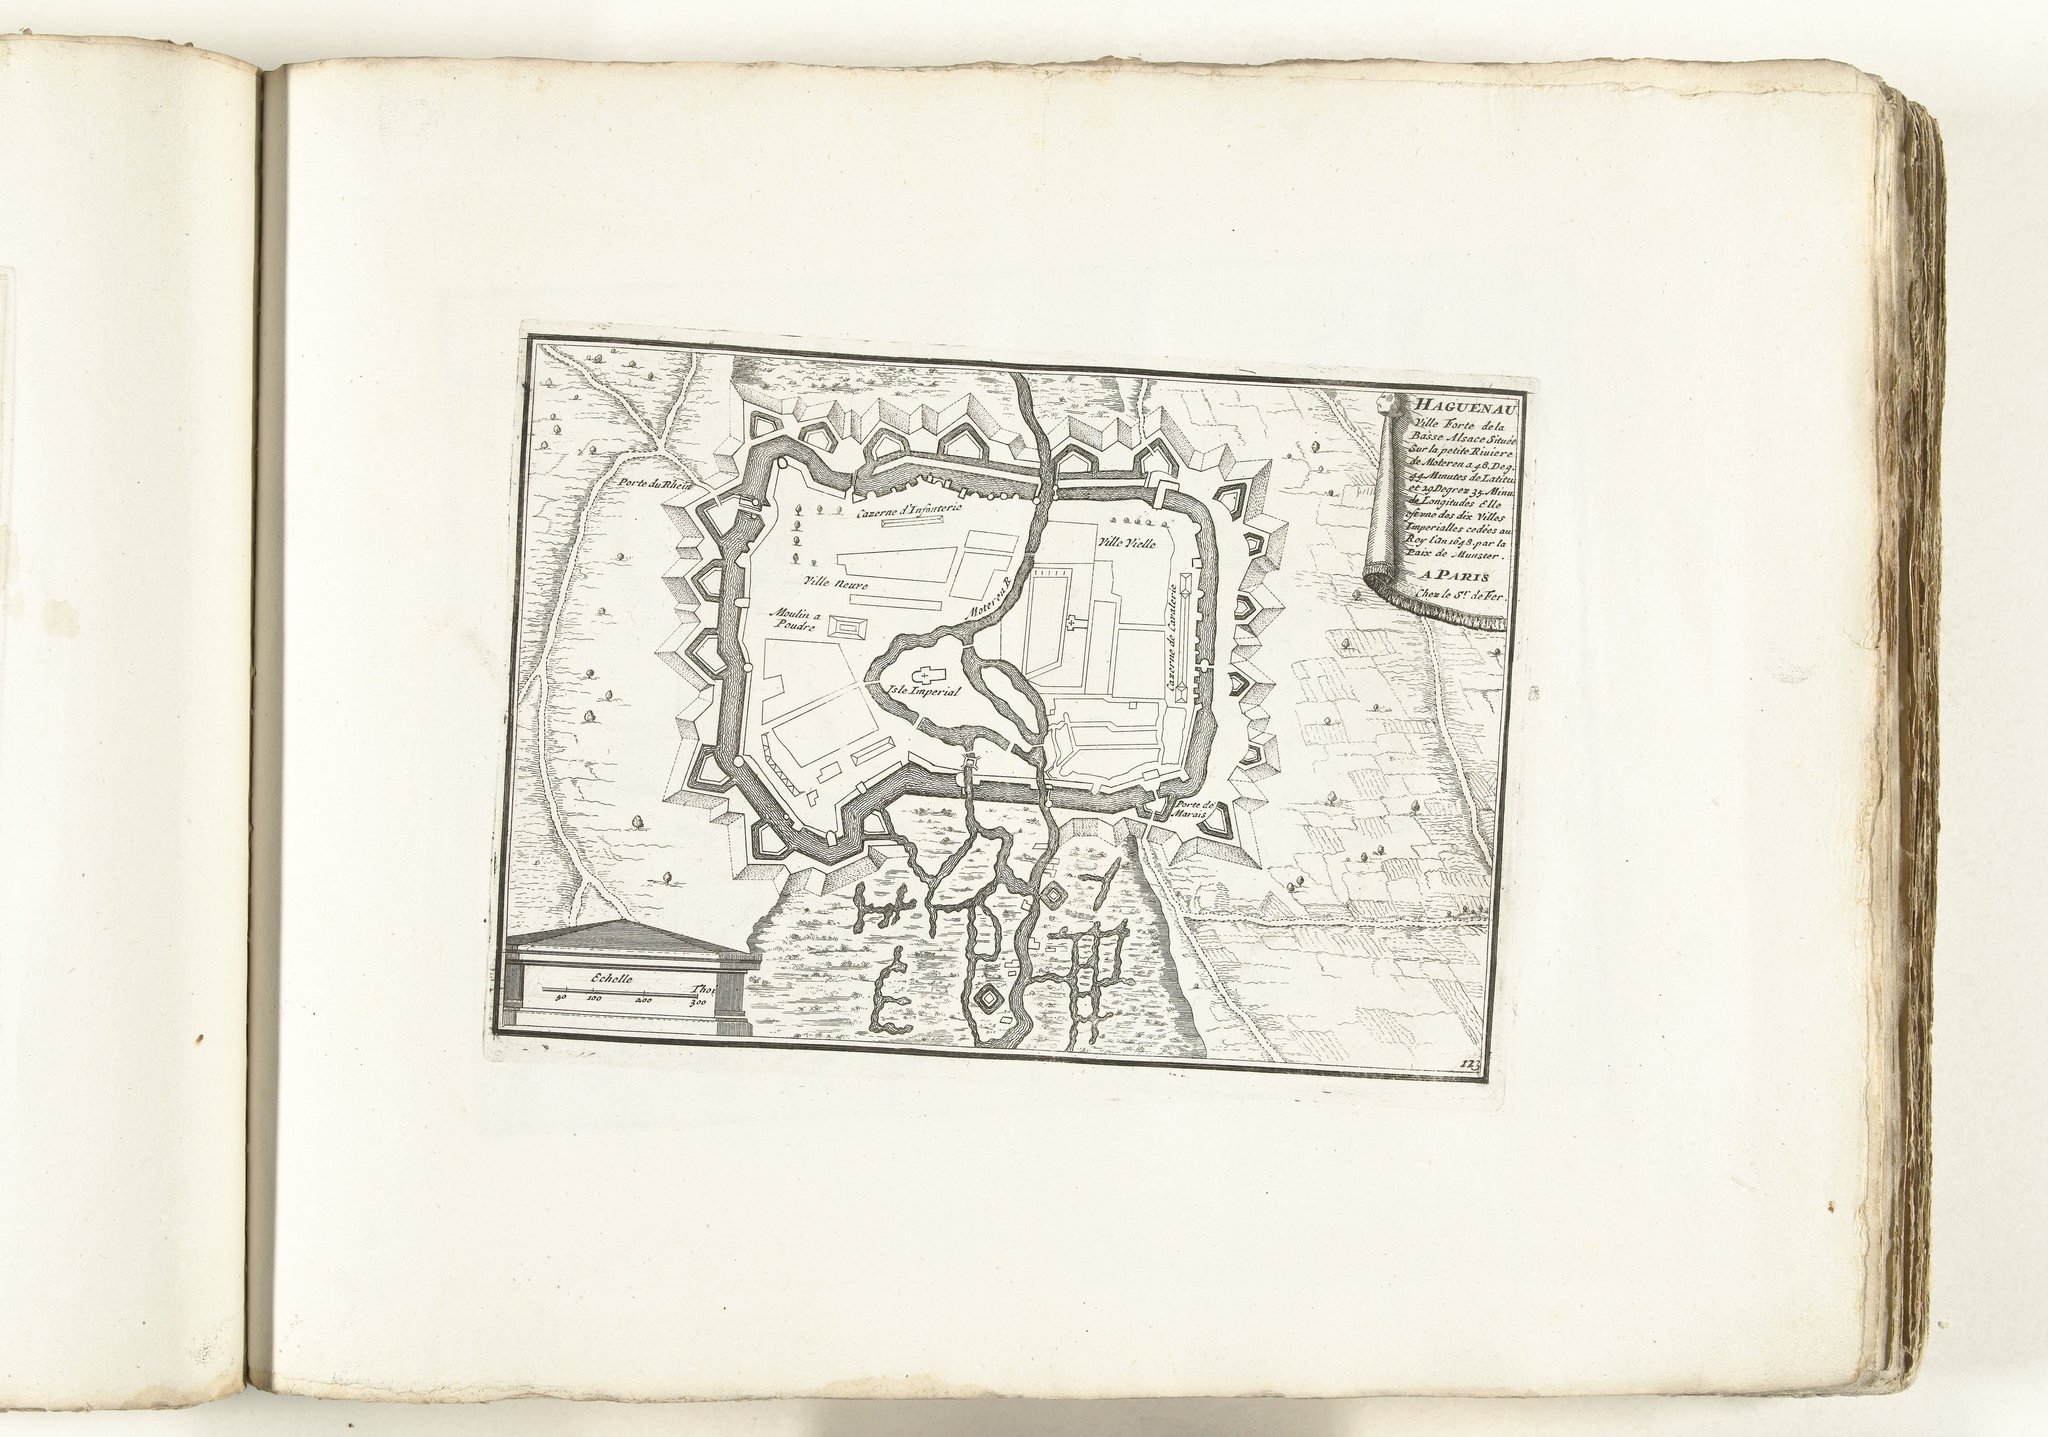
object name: map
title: Les Forces de l'Europe, Asie, Afrique et Amerique, ou description des principales villes avec leurs fortifications. Dessignées par les meilleurs ingenieurs, particulierement celles qui sont sous la domination de la France (...) et ornées de plusieurs superbes edifices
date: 1702-1703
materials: paper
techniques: etching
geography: paris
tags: fortress, maps of cities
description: Plattegrond van de versterkingen om de stad Haguenau. Plaat nr. 123 in het prentwerk bestaande in totaal uit 276 genummerde platen van vermaarde sterke steden en vestingen in het kader van de Spaanse Successieoorlog. Voor het merendeel zijn deze platen gekopieerd naar de anonieme Franse platen: in Les forces de l'Europe en in: Le theatre de la guerre, dans les Pays-Bas, beide oorspronkelijk uitgegeven door Nicolas de Fer te Parijs (1693-1697) in het kader van de Negenjarige Oorlog. Titel en opschriften in de plaat in het Frans.